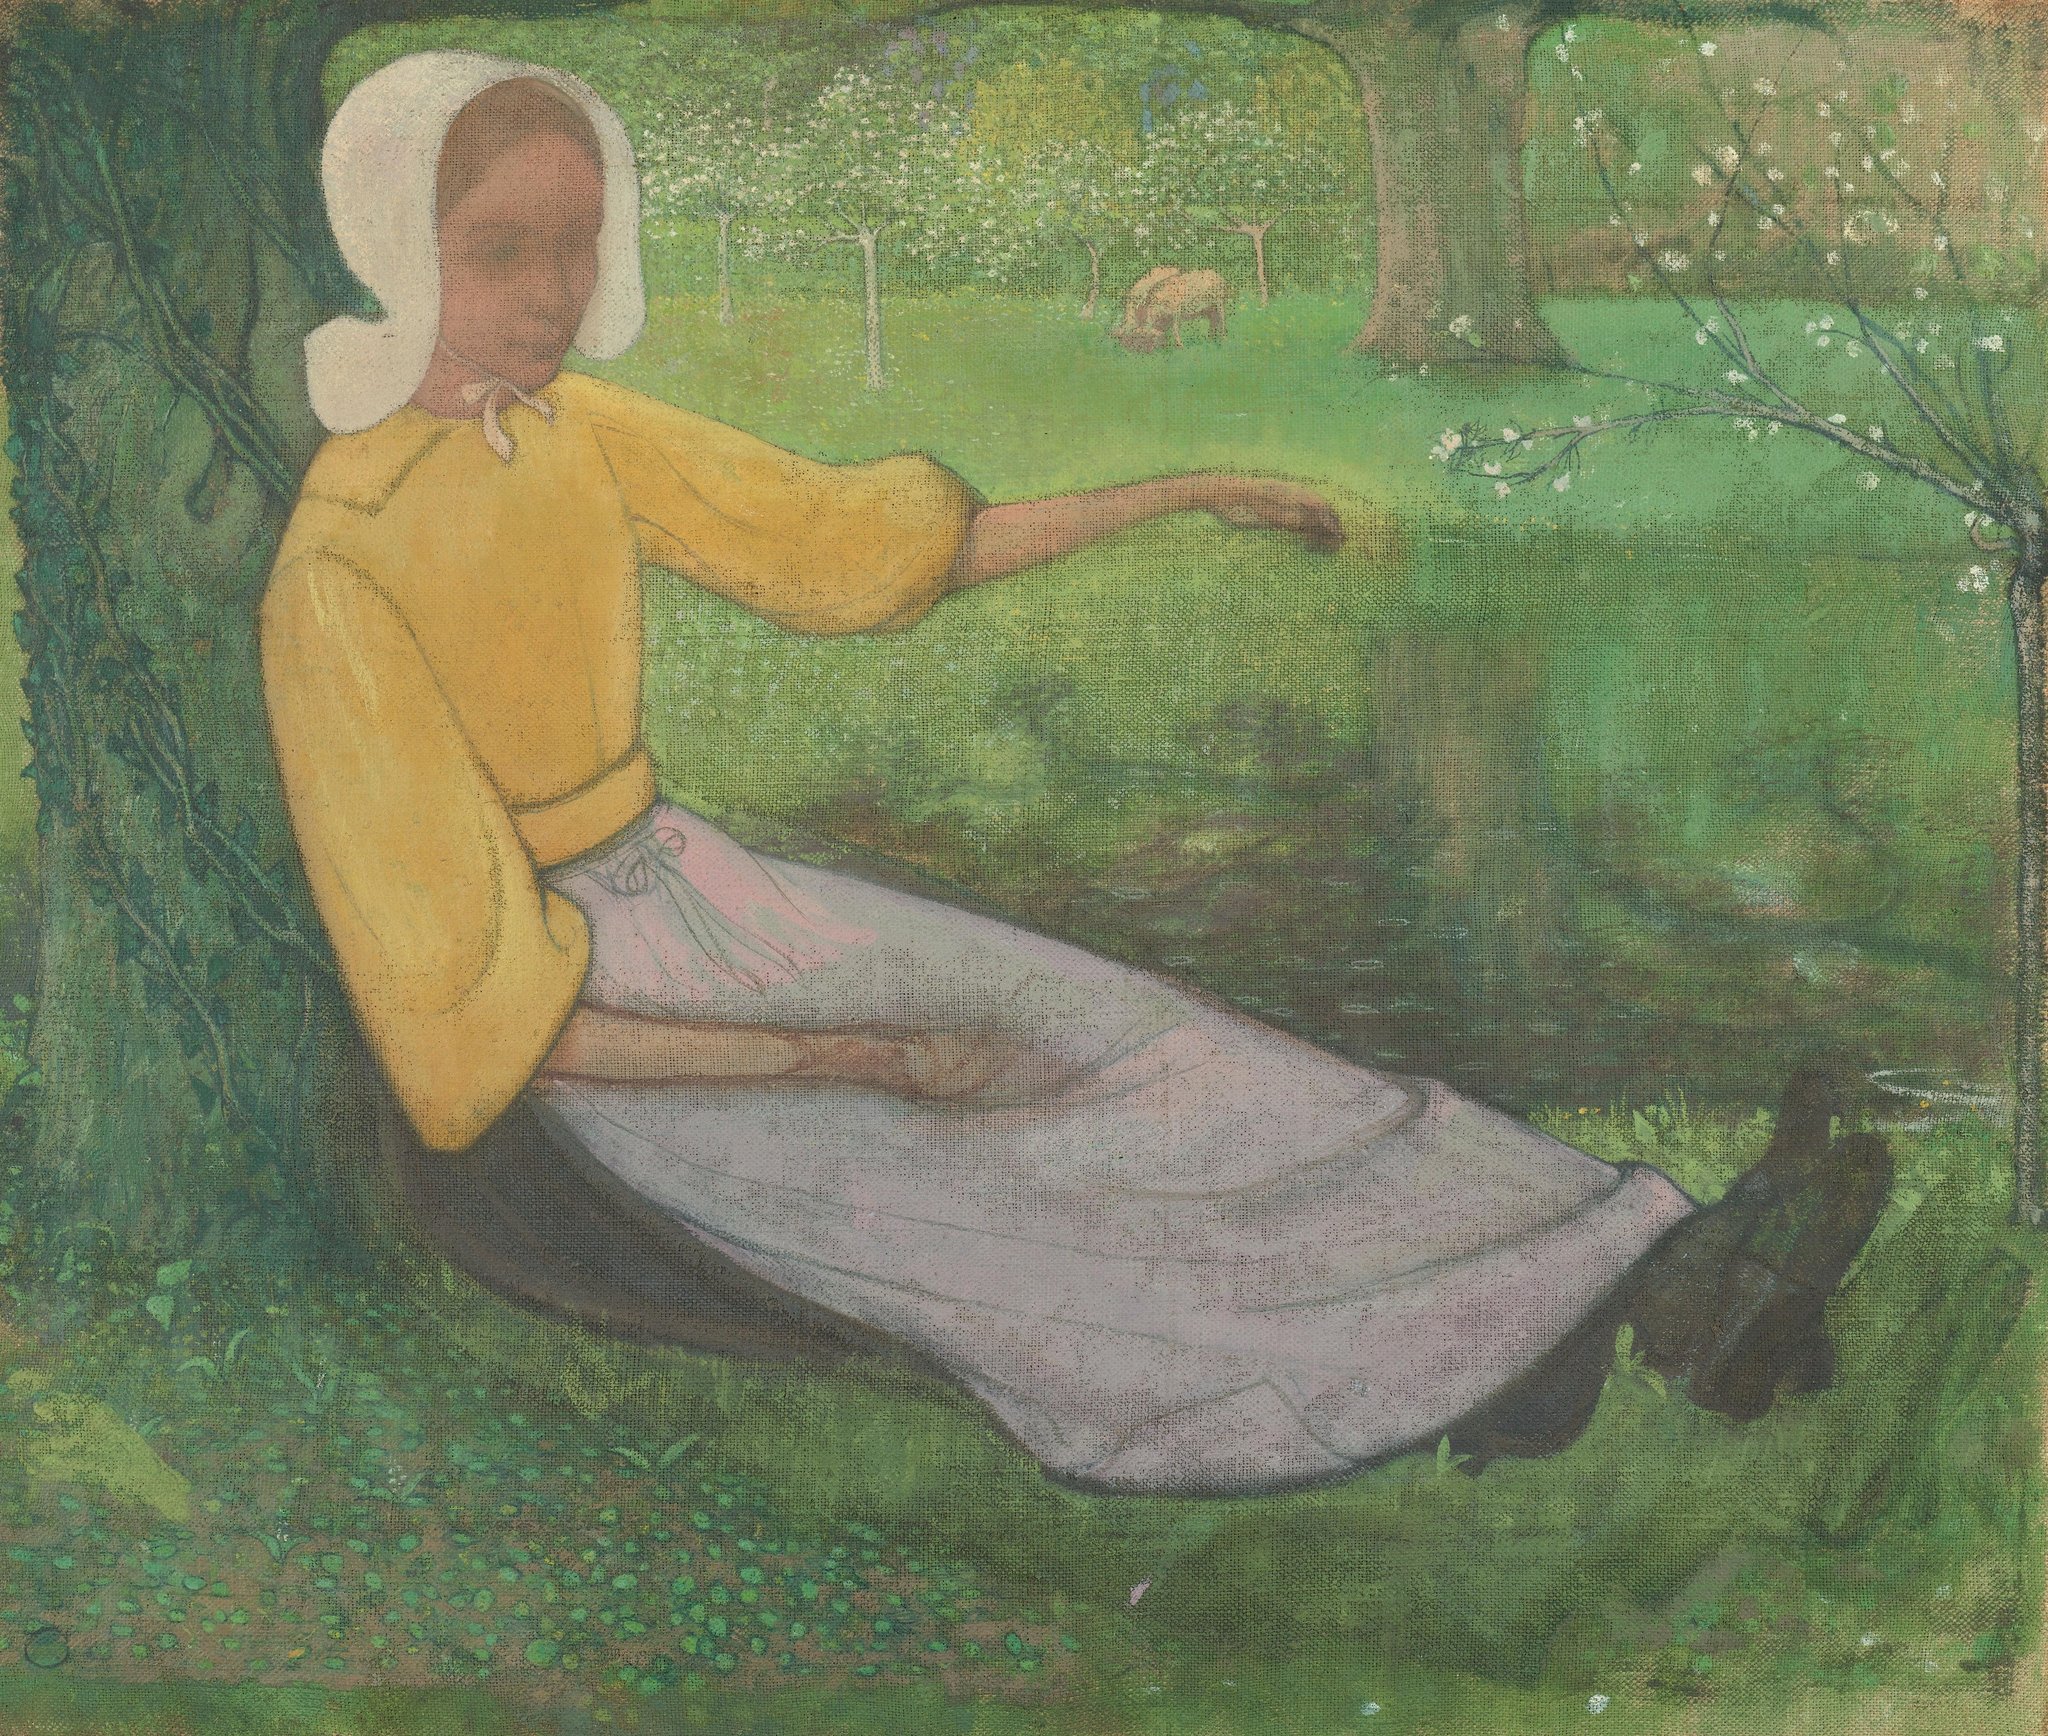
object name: painting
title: Woman of Huizen sitting under a Tree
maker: richard nicolaüs roland holst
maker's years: 1868-1938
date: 1888-1895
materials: canvas, oil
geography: netherlands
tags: adolescent, young woman, maiden, trees, girl (child between toddler and youth), folk costume, regional costume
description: Een meisje uit Huizen zittend onder een boom bij een vijver. Op het hoofd een witte kap, aan de overkant van het water grazen schapen.